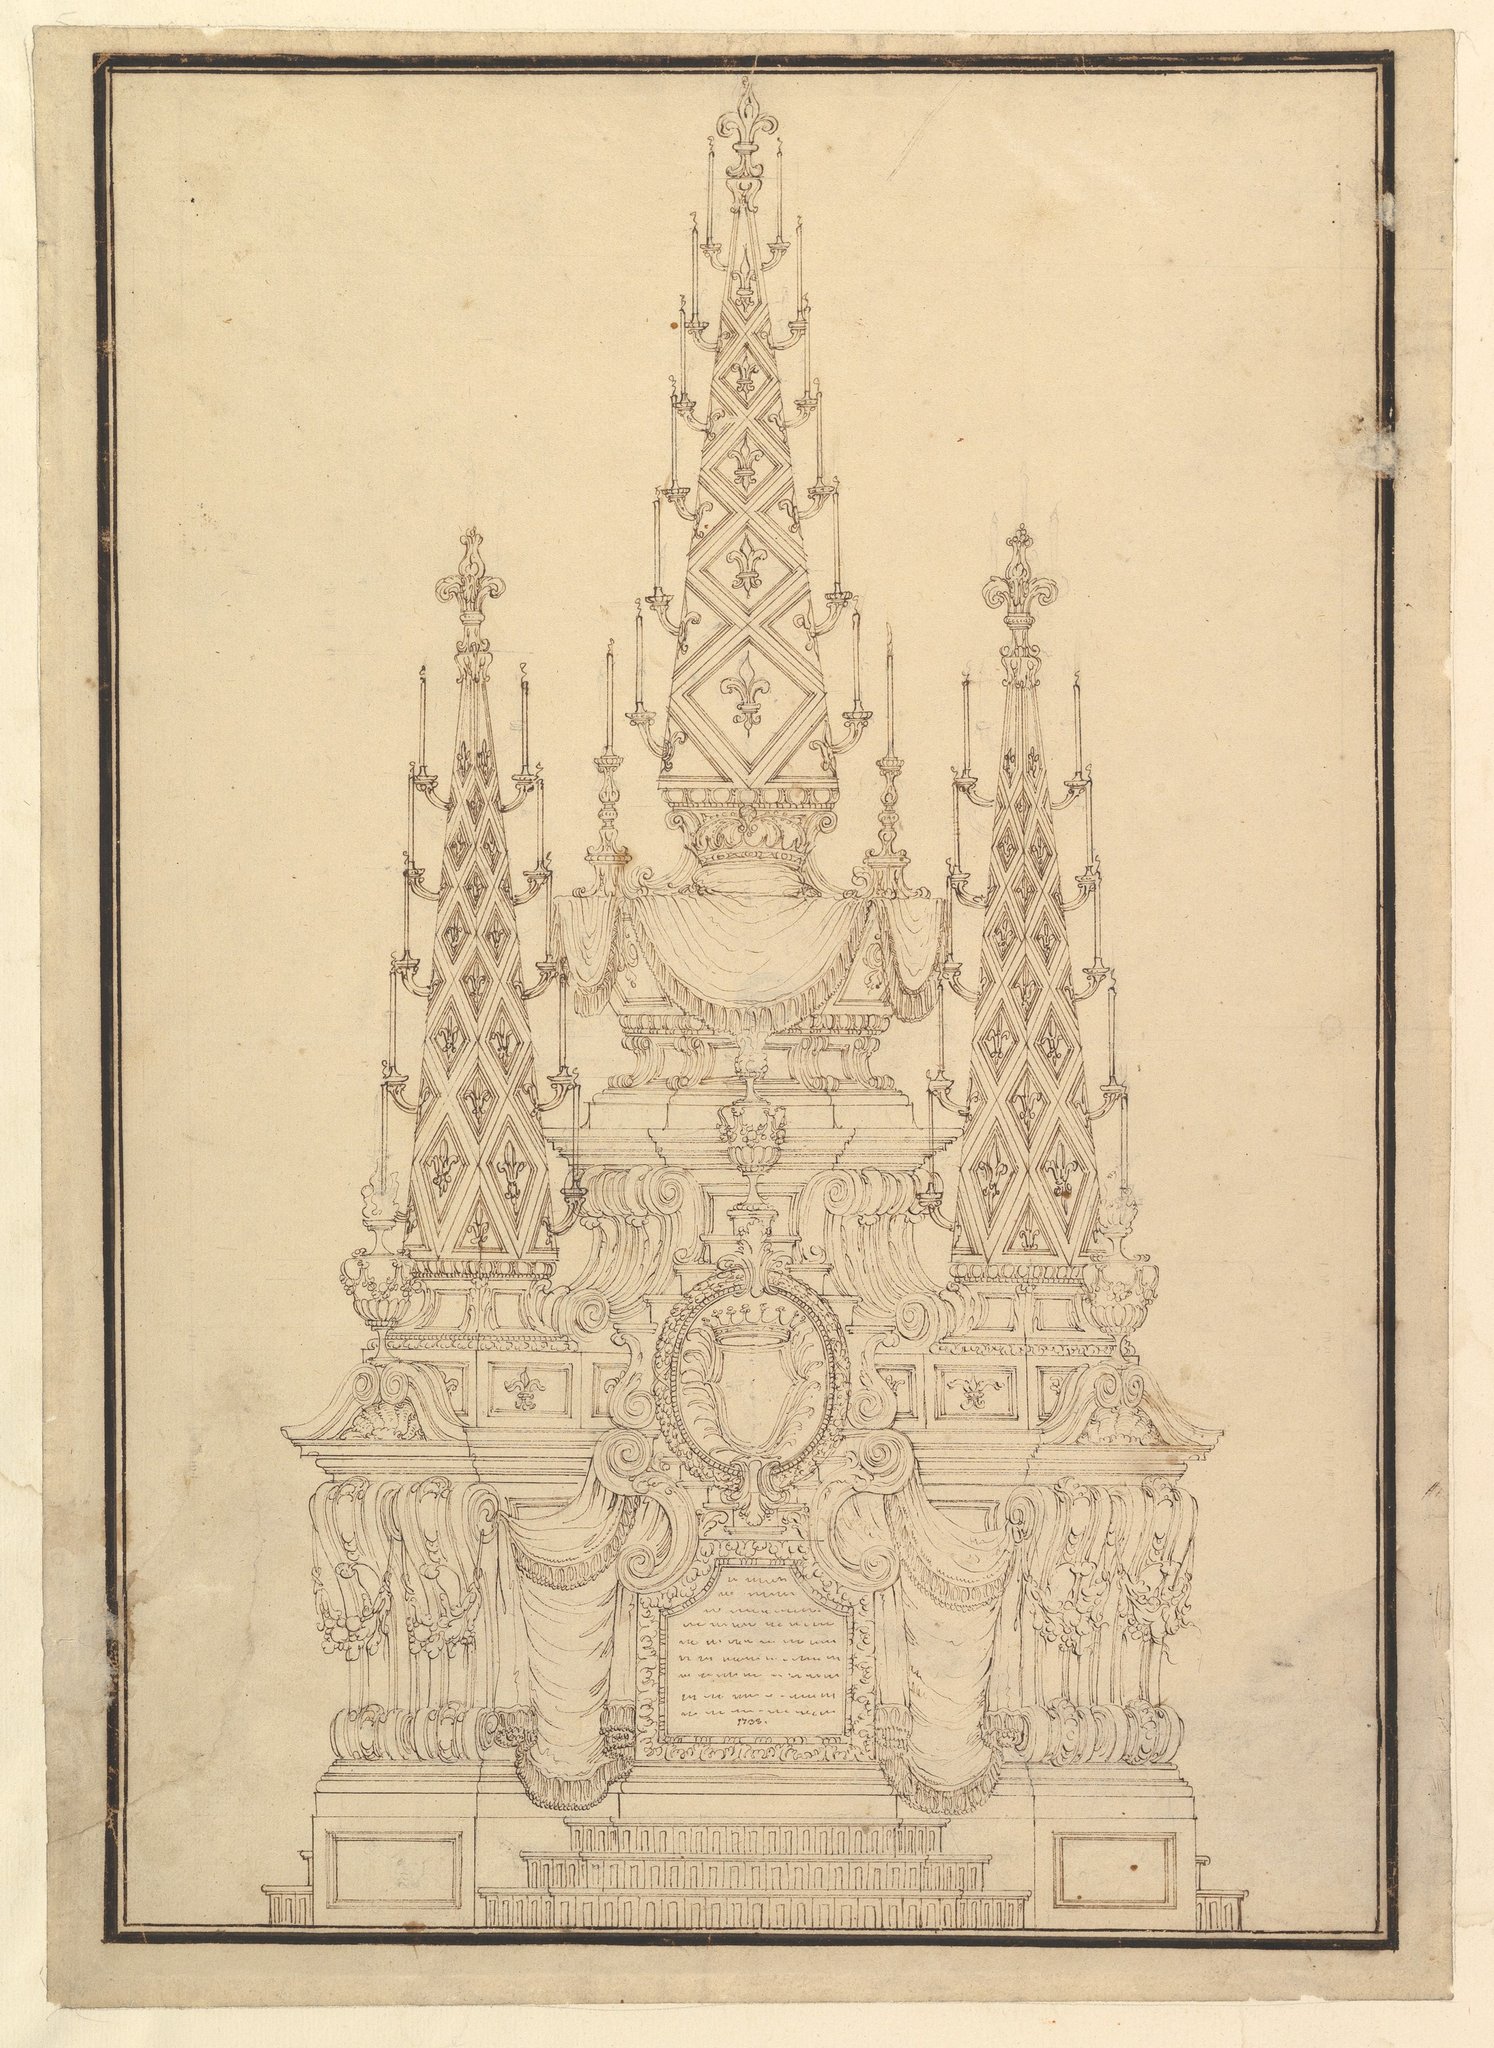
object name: drawing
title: Elevation of a Catafalque, Three Obelisks with Fleur-de-lys and Candles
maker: giuseppe galli bibiena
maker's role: artist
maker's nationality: italian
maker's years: 1696-1756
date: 1733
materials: ink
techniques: pen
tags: obelisks,emblems